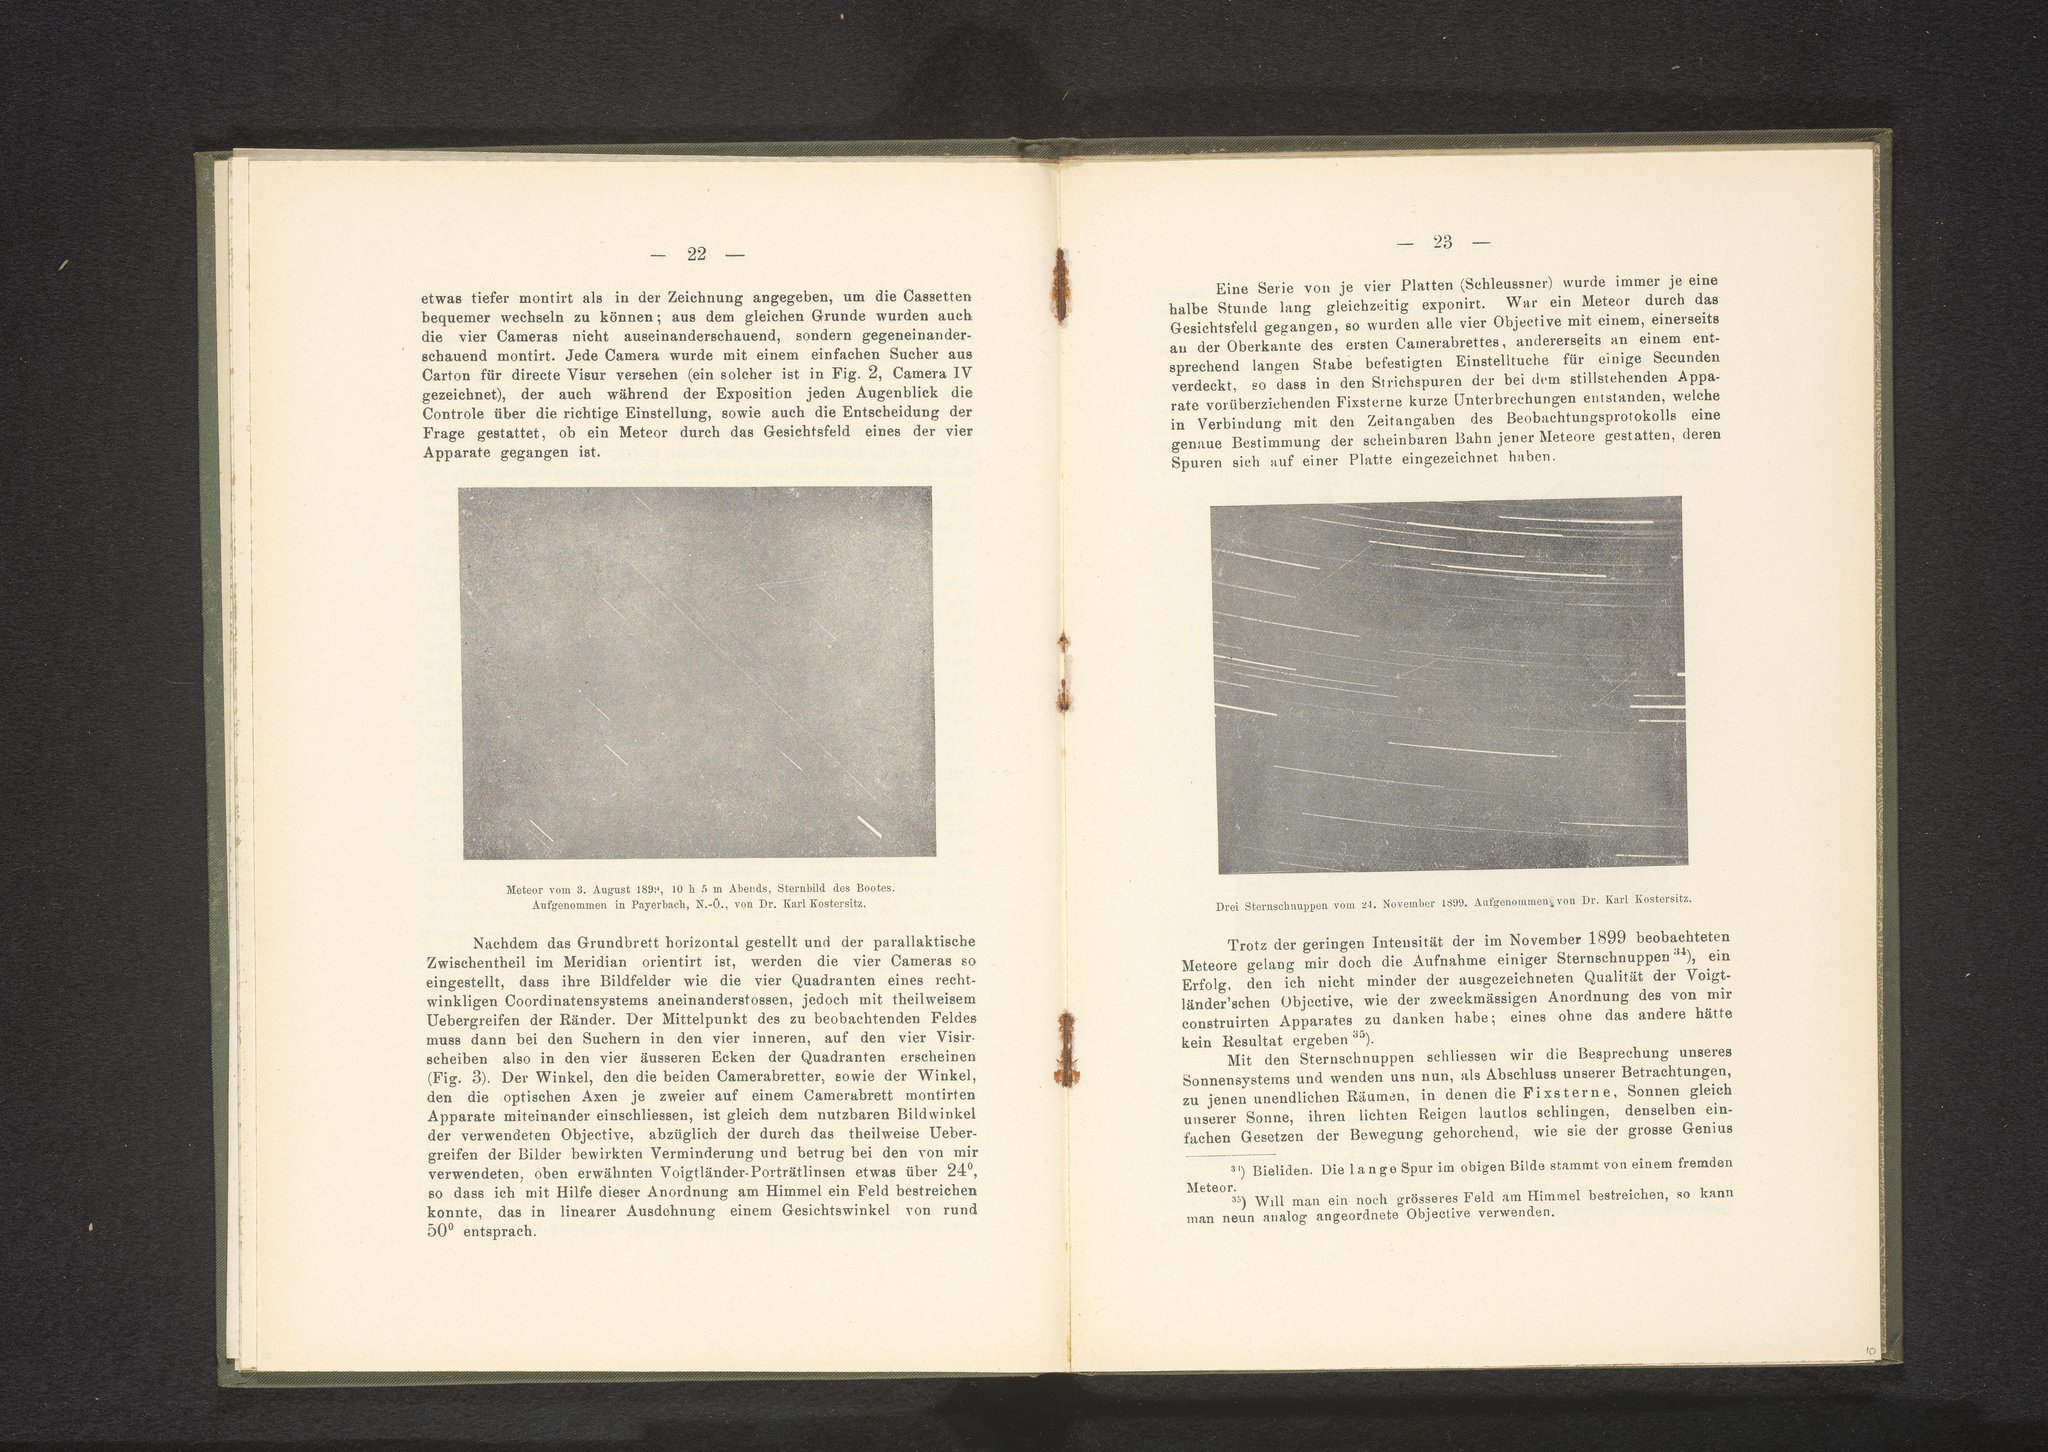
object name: photomechanical print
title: Drei Sternschnuppen vom 24. November 1899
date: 1899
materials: paper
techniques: autotype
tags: meteor